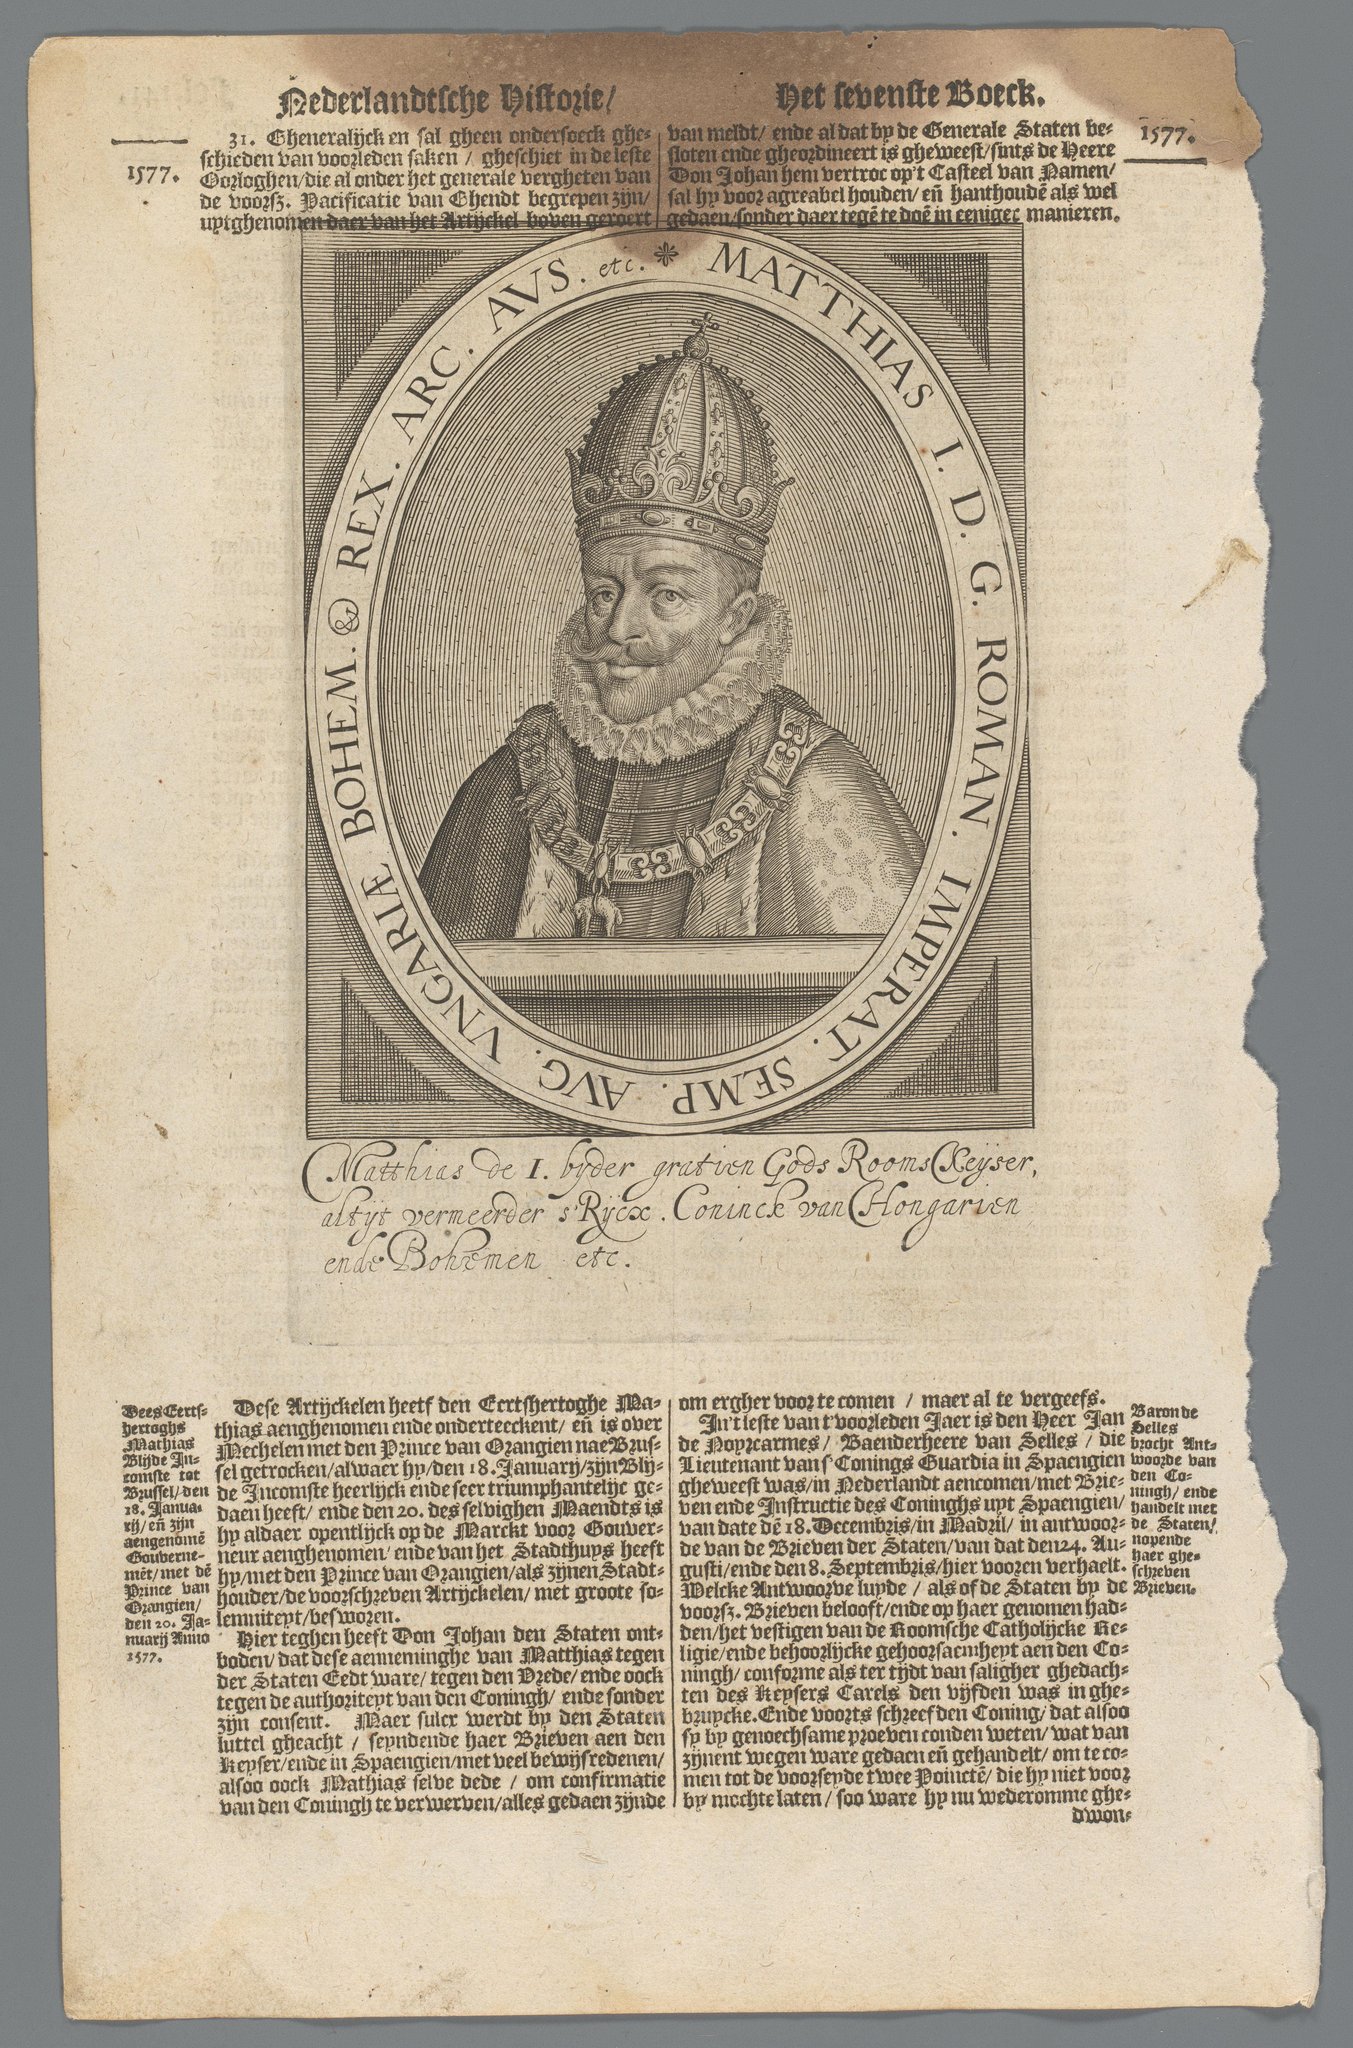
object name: text sheet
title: Matthias i.d.g. Roman imperat. semp. Aug. Ungariae Bohem. & rex. arc. Aus. etc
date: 1614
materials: paper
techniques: engraving, letterpress printing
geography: the hague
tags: vienna, matthias van oostenrijk (rooms-duits keizer), historical persons, emperor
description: Prent uit: Meteren, Emanuel van. Historie der Nederlandscher ende haerder na-buren oorlogen ende geschiedenissen (...). Den Haag: Hillebrant Iacobsz. van Wouw, 1614.